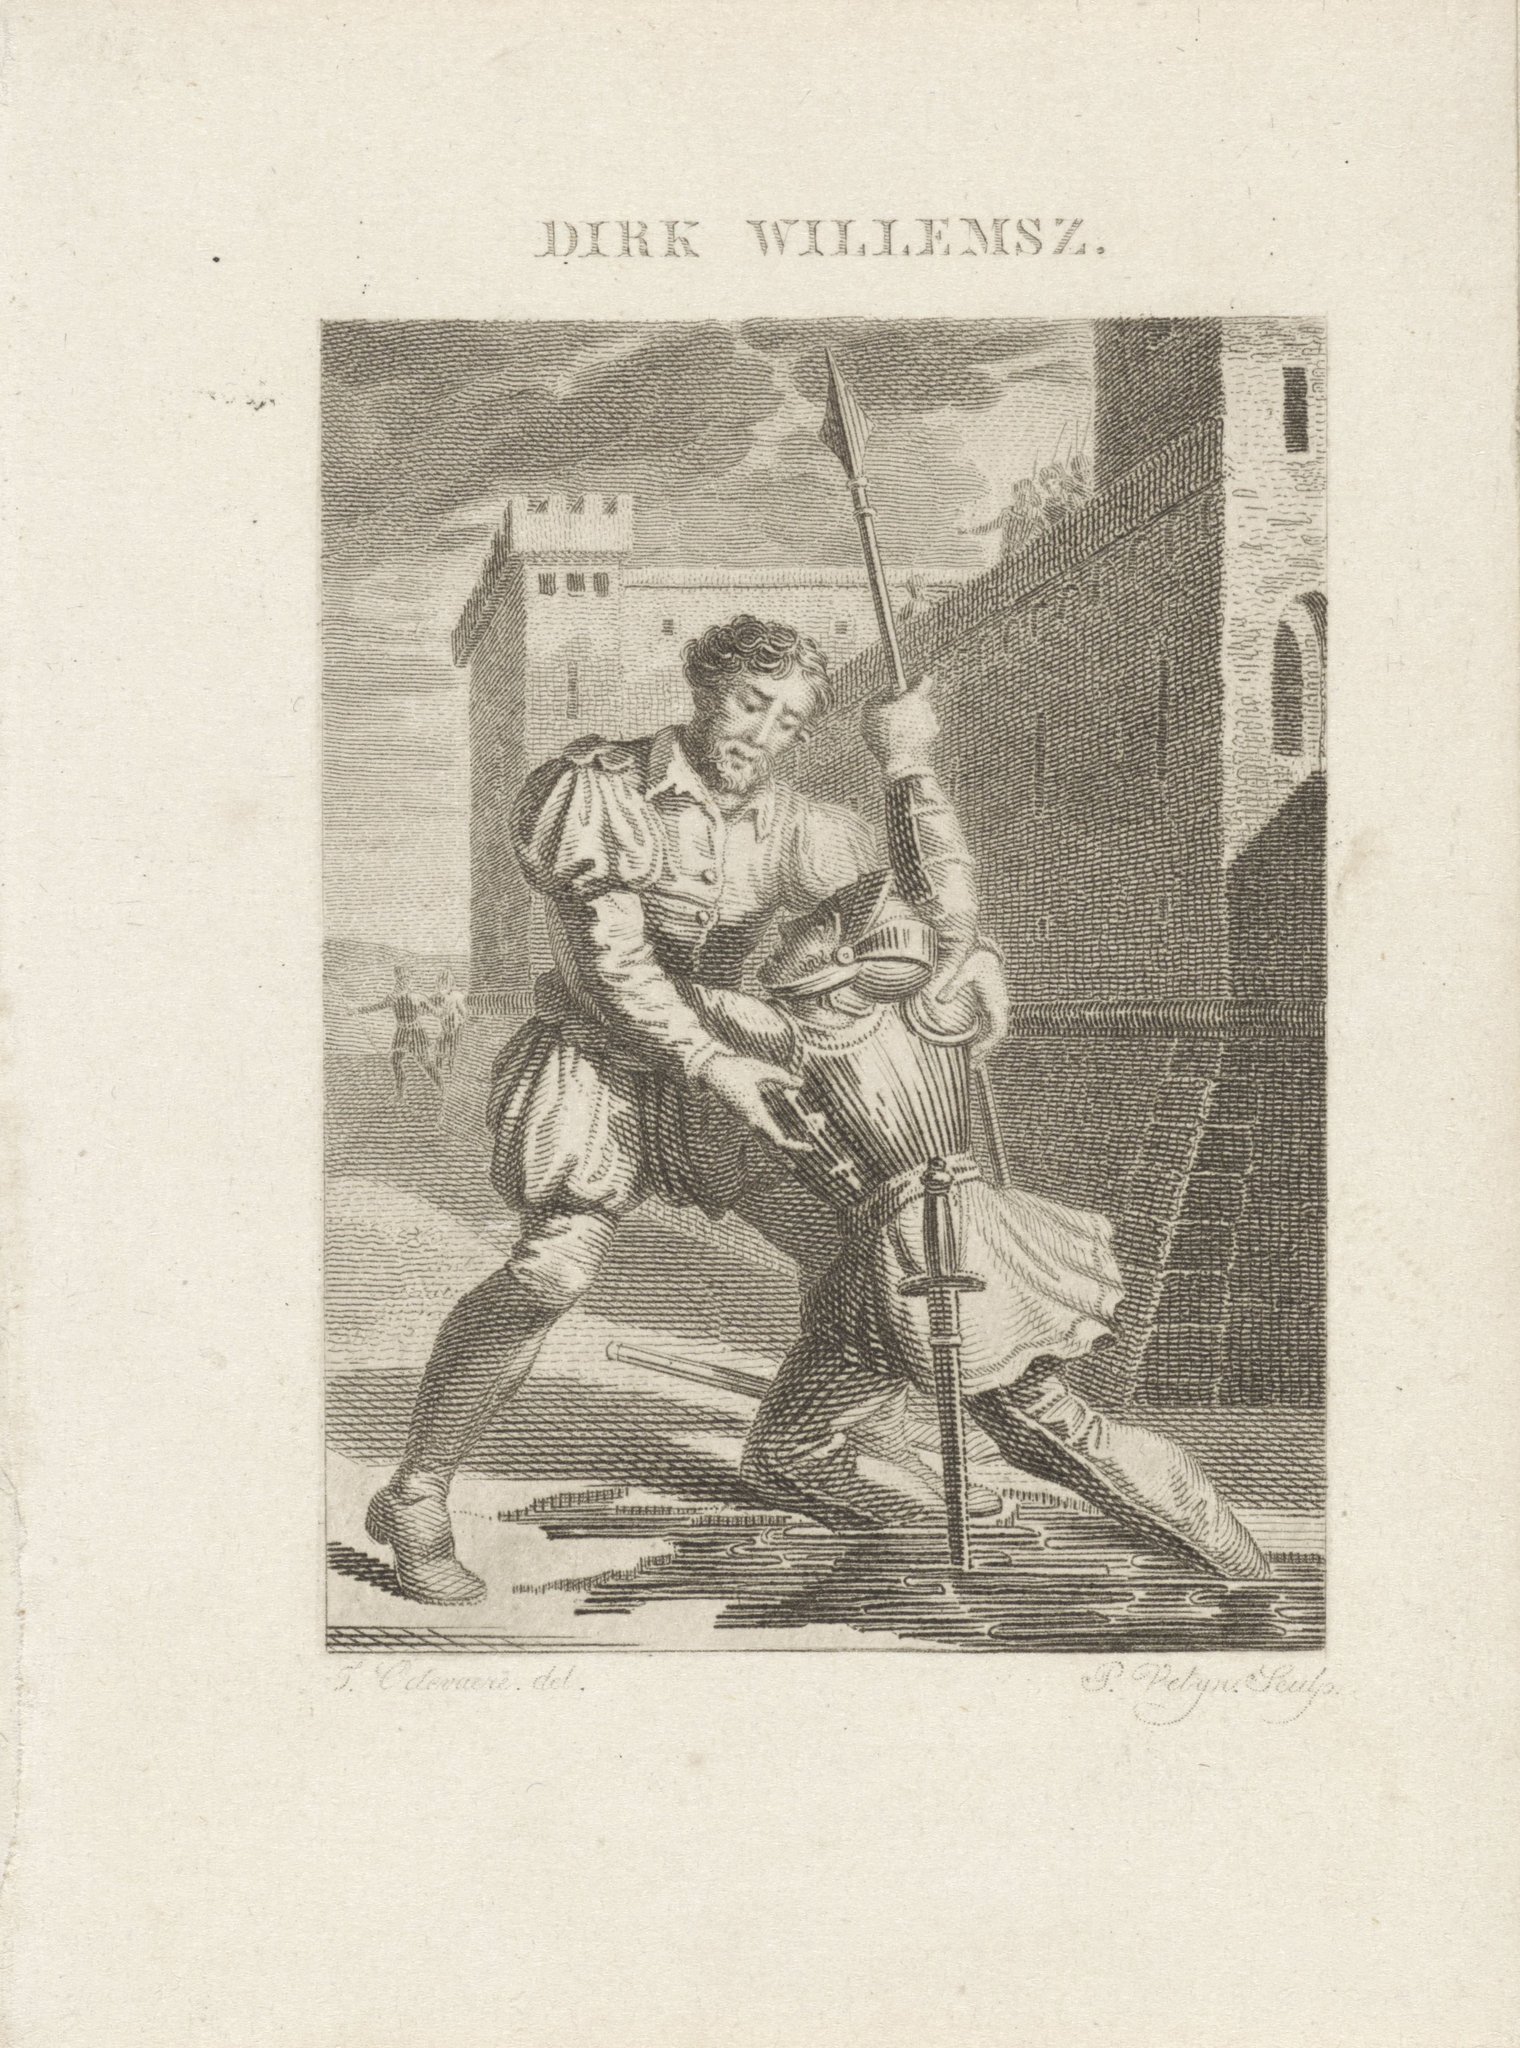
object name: print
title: Dirk Willemsz redt zijn achtervolger uit het water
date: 1819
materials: paper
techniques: engraving, etching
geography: netherlands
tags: saving a person from drowning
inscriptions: collector's mark: Lugt 2228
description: De doopsgezinde martelaar Dirk Willemsz redt, nadat hij is ontsnapt uit de gevangenis, zijn achtervolger uit het water.